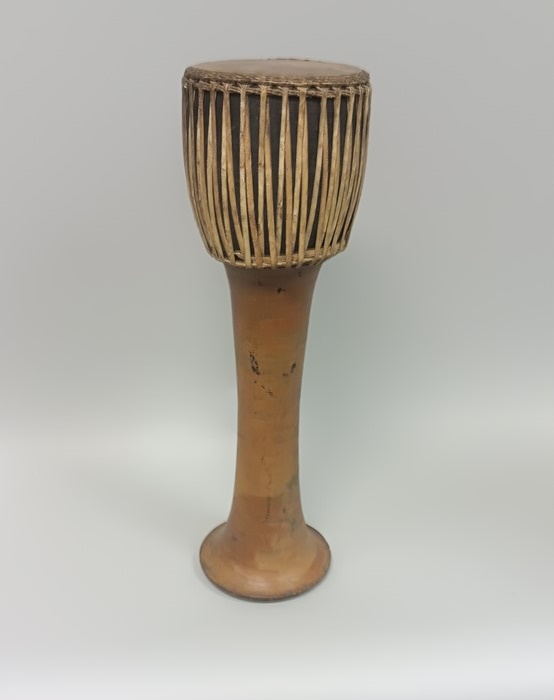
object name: ozi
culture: burmese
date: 1867-1900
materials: skin, wood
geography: myanmar